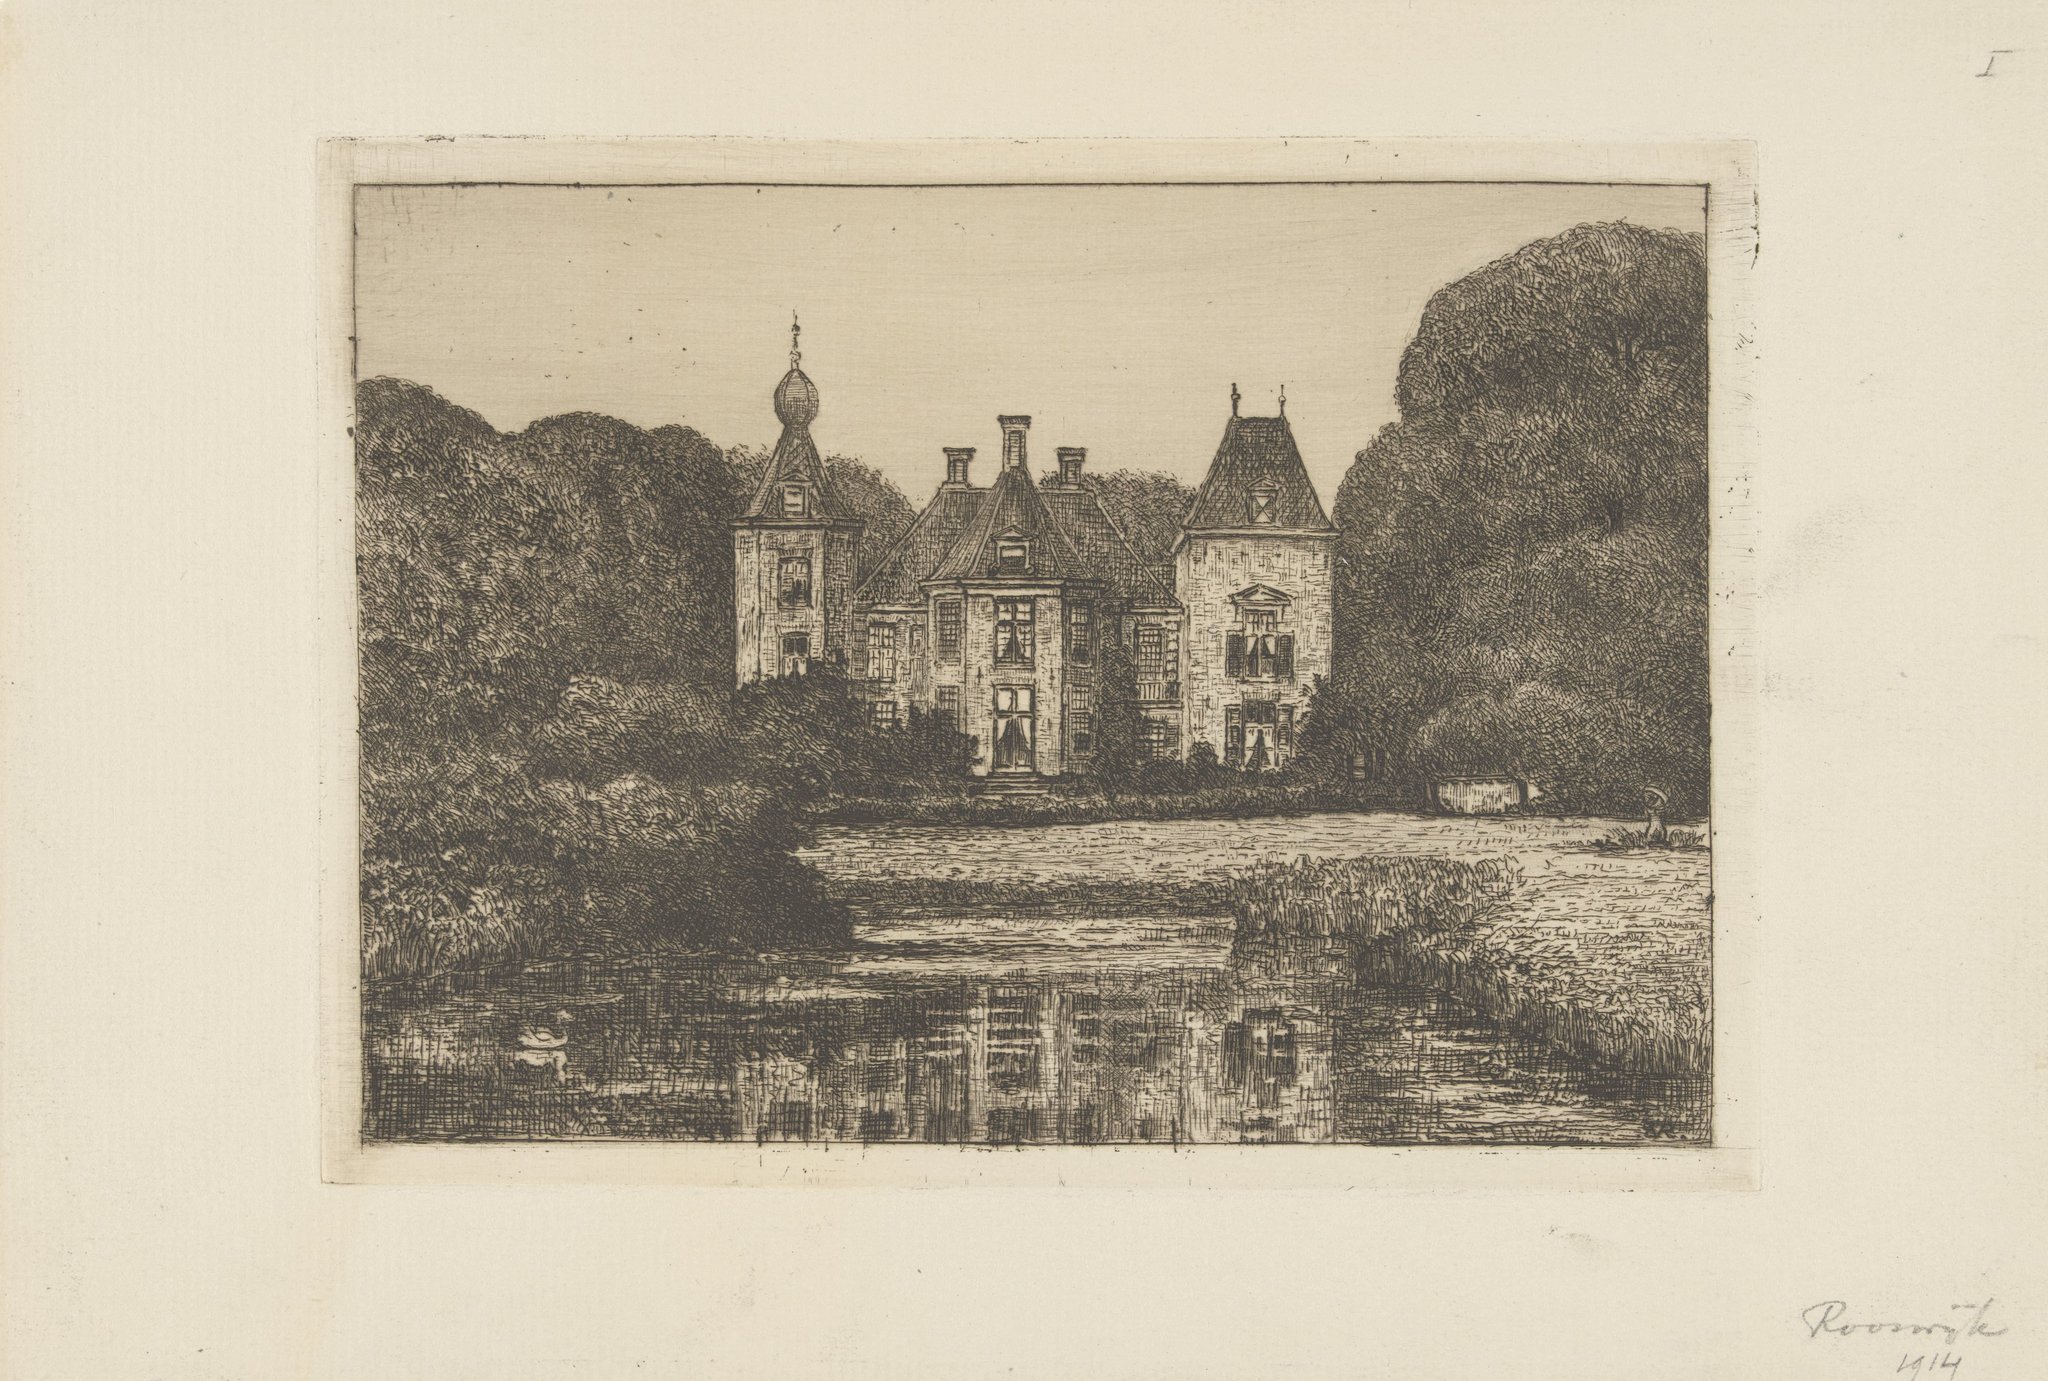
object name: print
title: Huis Rooswijk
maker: jonkheer barthold willem floris van riemsdijk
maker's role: engineer, print maker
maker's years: 1850-1942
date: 1914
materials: paper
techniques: drypoint, etching, intaglio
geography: netherlands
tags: country-house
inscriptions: inscription: ‘Rooswijk 1914’, collector's mark: Lugt 2228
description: Gezicht op Huis Rooswijk. De buitenplaats ligt aan een vijver en is aan de achterzijde door bomen omsloten.